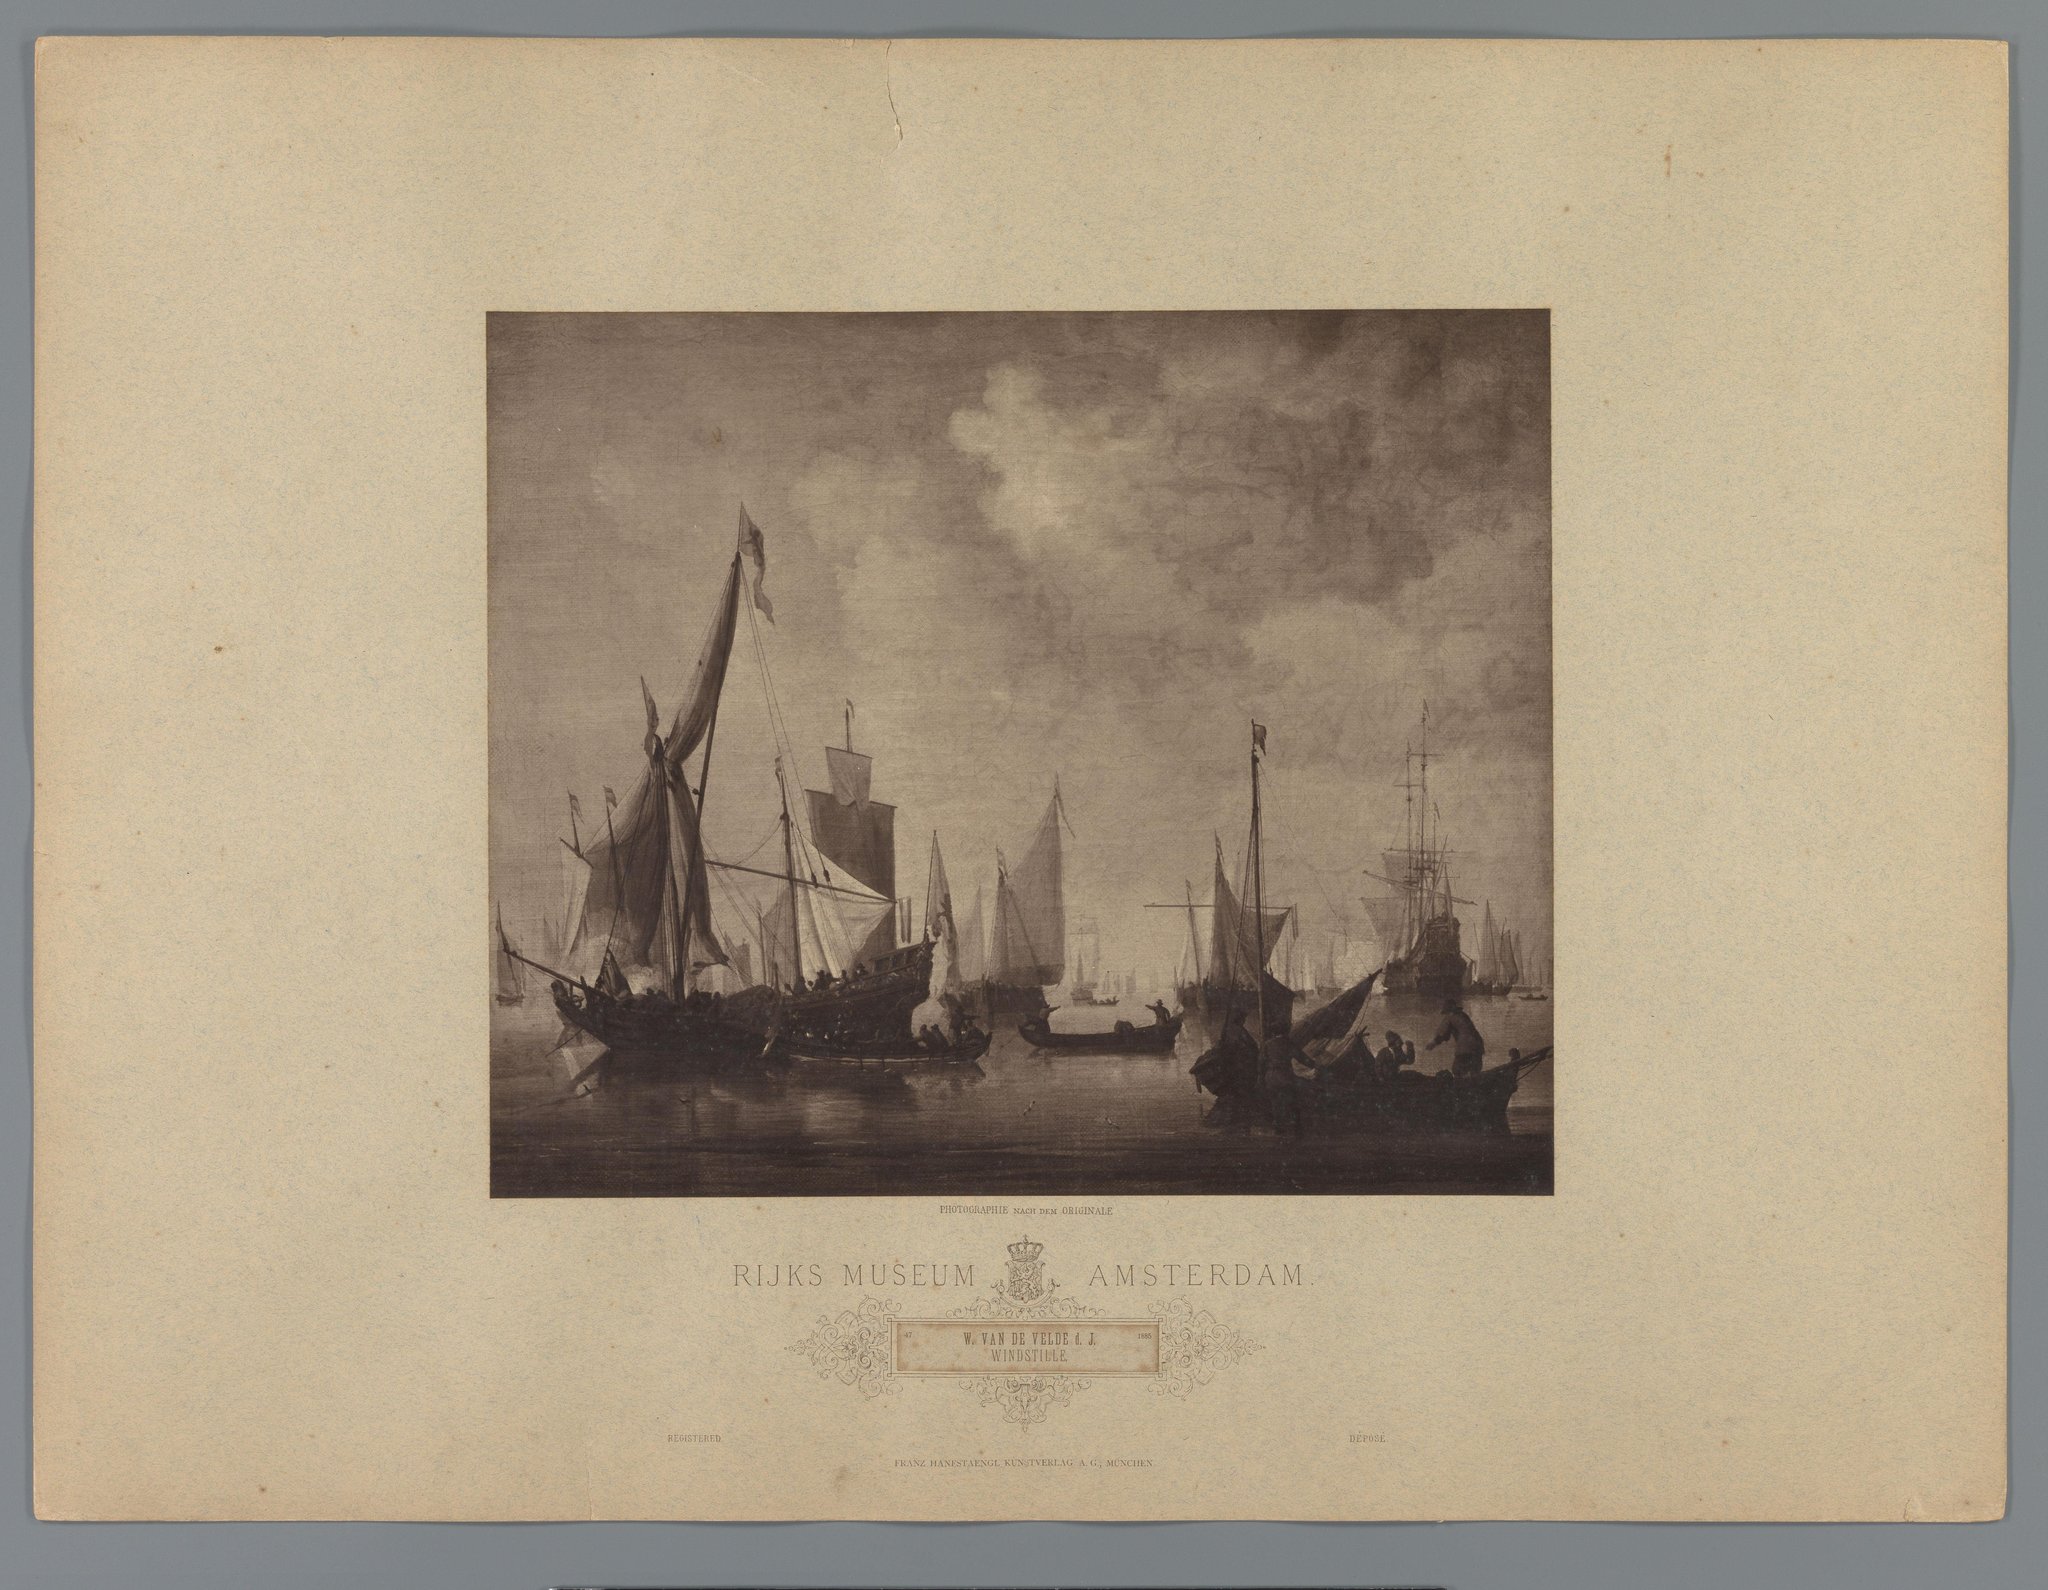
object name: photograph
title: W. van de Velde d. J. Windstille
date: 1885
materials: cardboard, paper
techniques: carbon print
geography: amsterdam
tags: absence of wind, calm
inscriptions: inscription: ‘Photographie nach dem Originale/ Rijks Museum Amsterdam/ Registered. Déposé.’, number: ‘47’